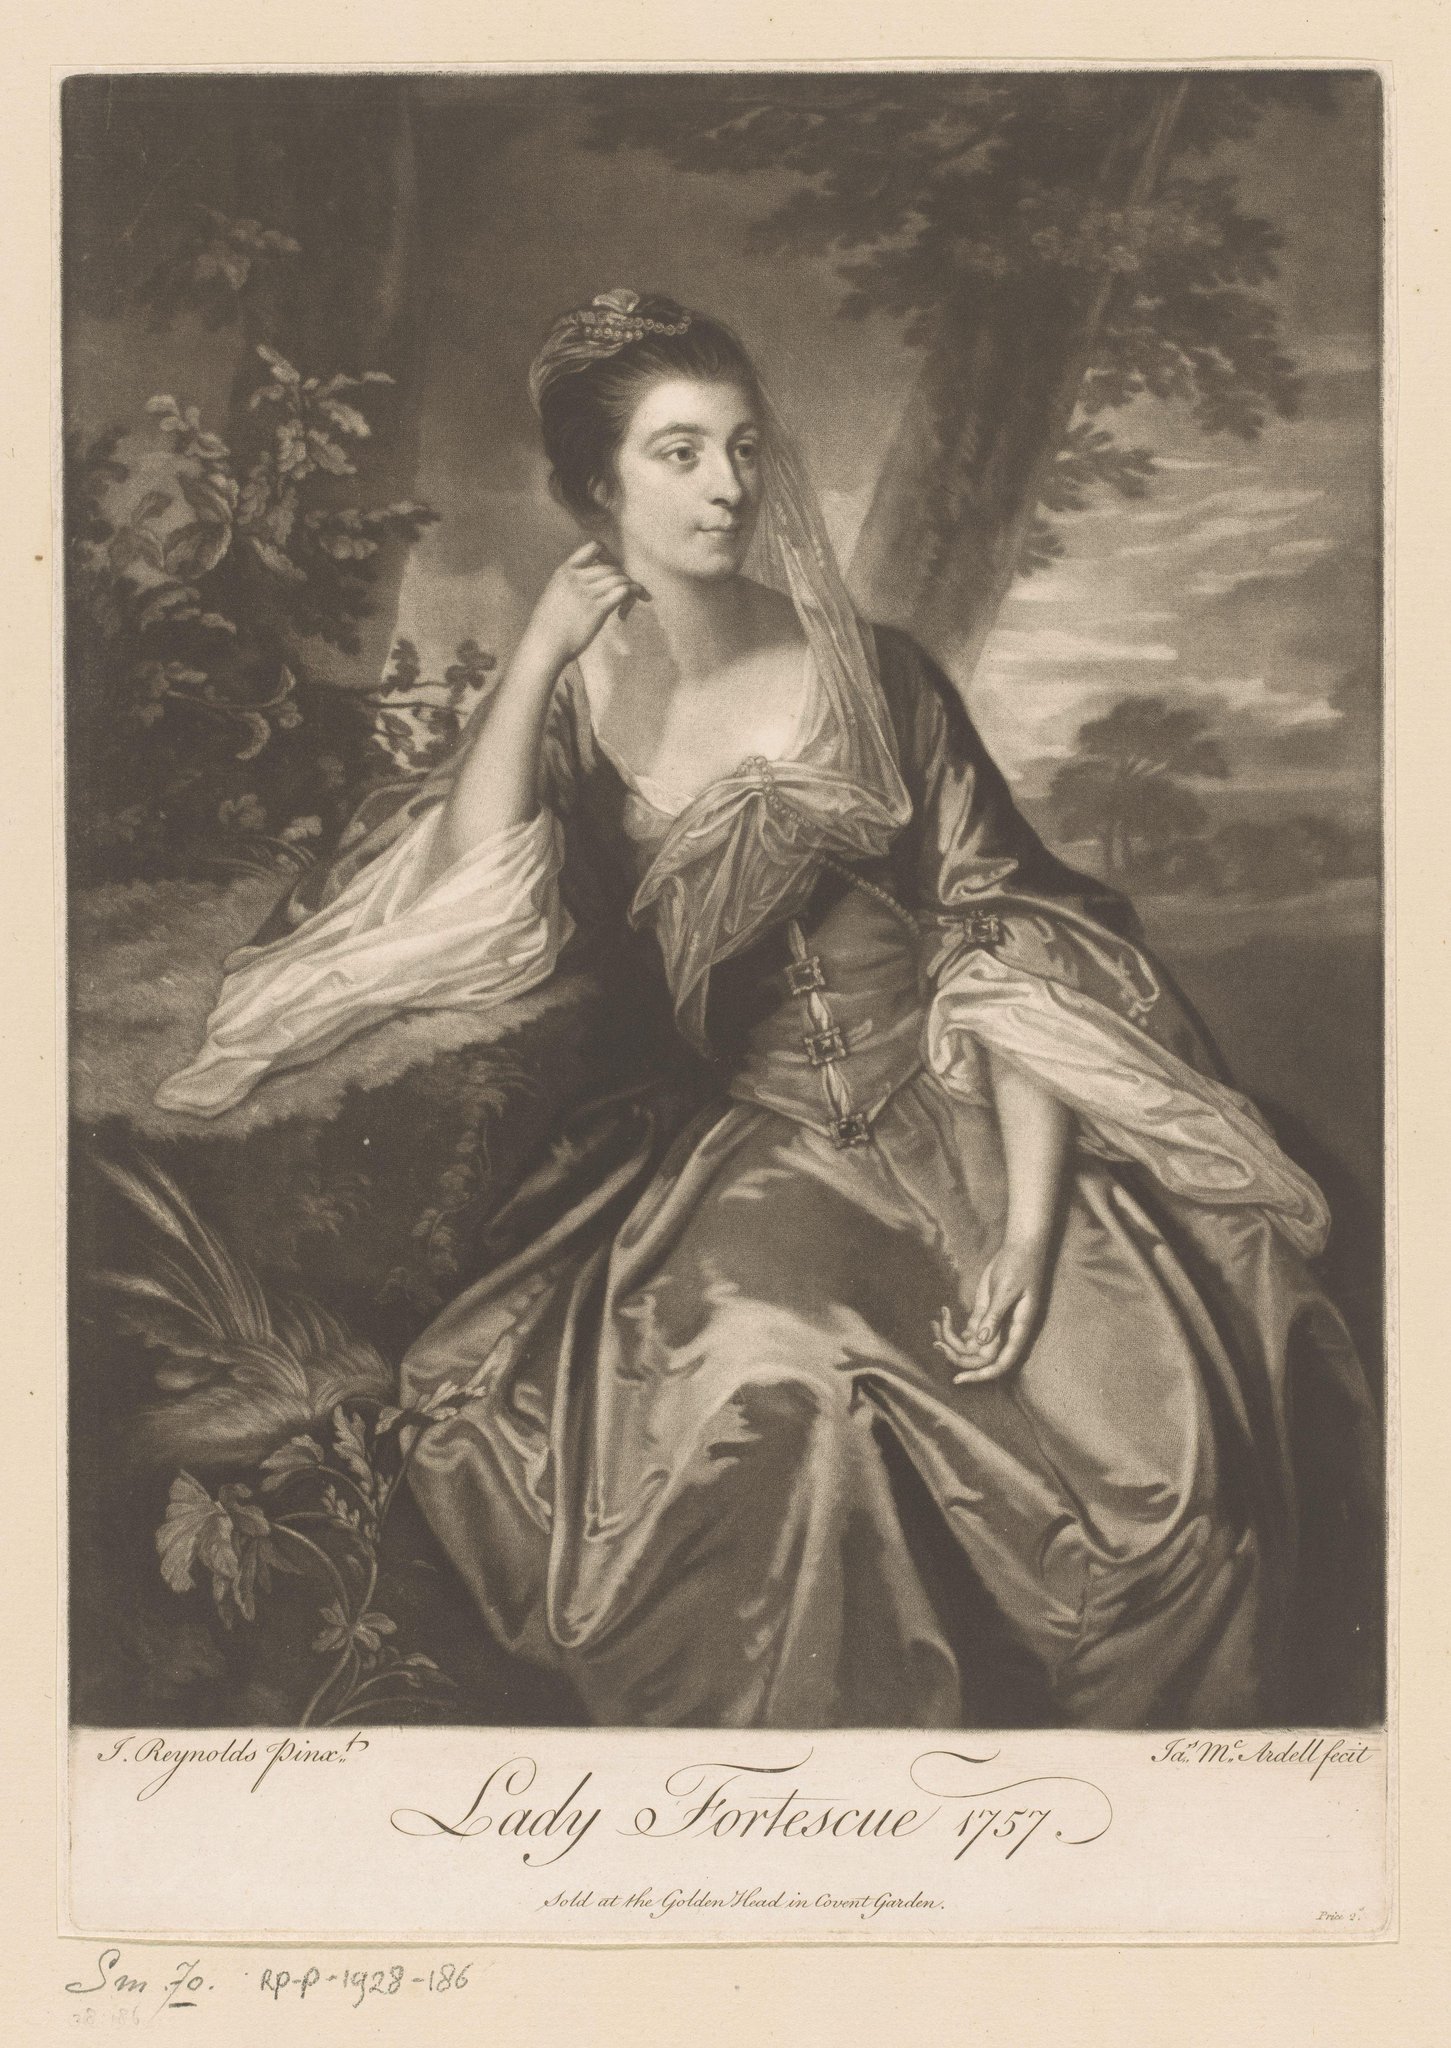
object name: print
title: Portret van Anne Fortescue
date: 1757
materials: paper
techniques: mezzotint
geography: london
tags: historical persons - bb - woman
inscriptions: collector's mark: Lugt 2228